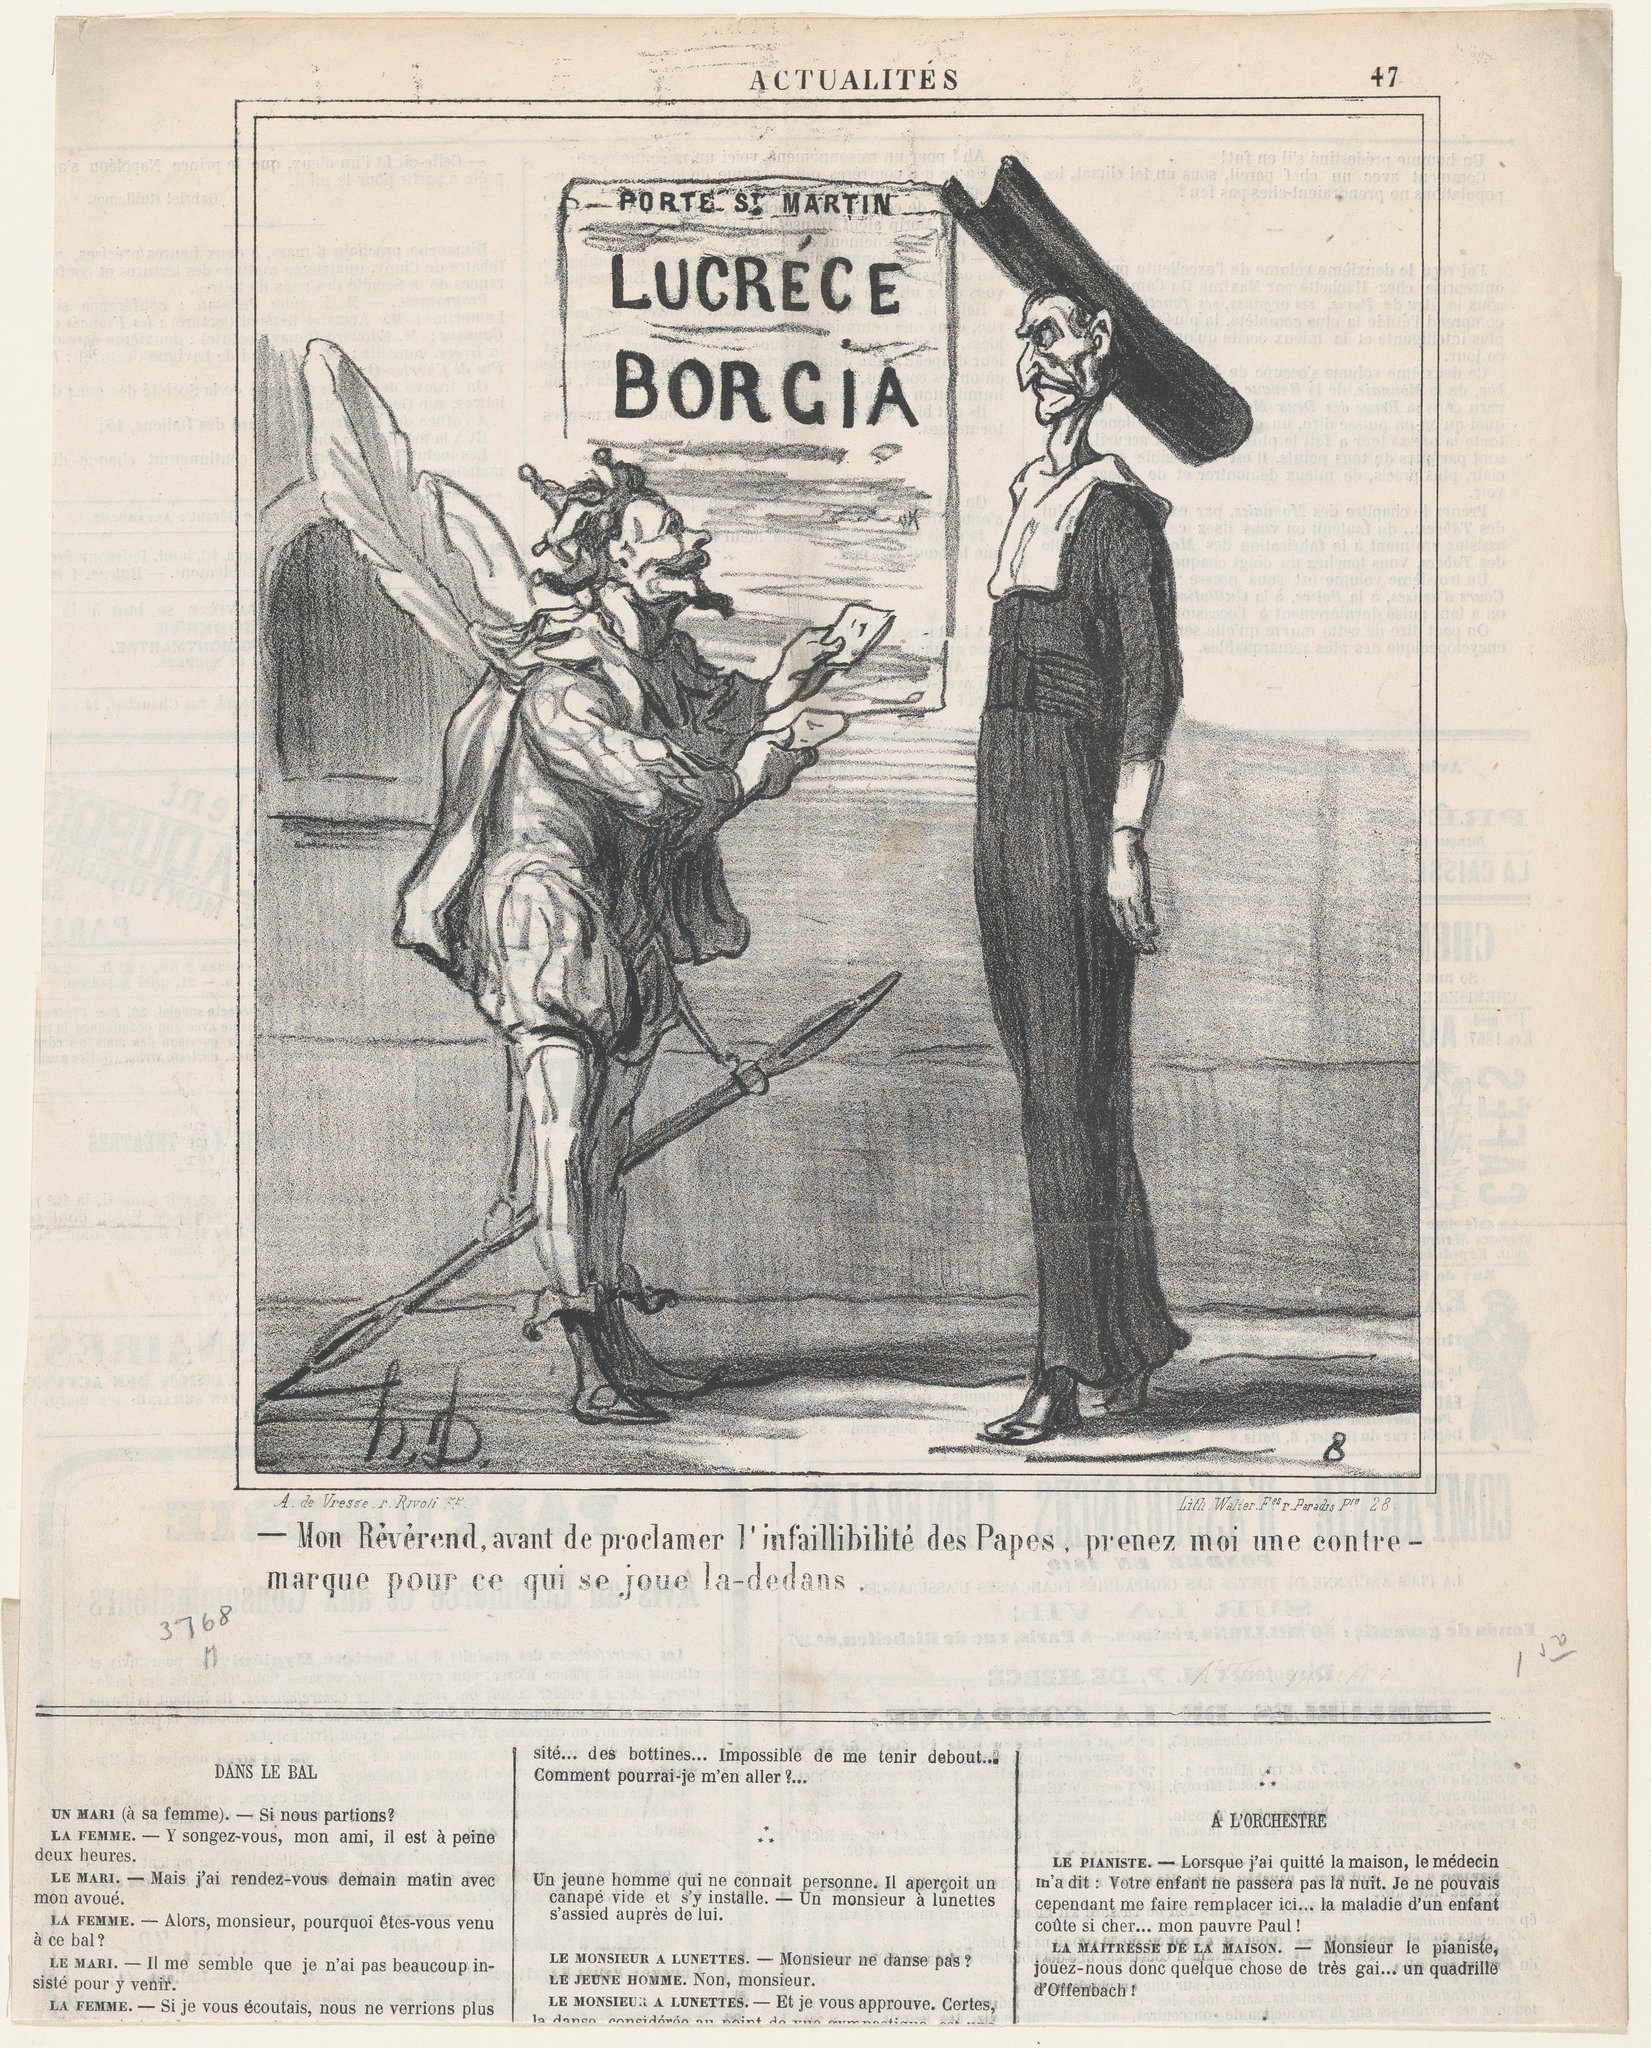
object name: print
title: Reverend, before proclaiming the infallibility of the Pope, please get your entrance ticket for the play in there, from 'News of the day,' published in Le Charivari, March 5, 1870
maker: honoré daumier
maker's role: artist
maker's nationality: french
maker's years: 1808-1879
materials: paper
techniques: lithograph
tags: men